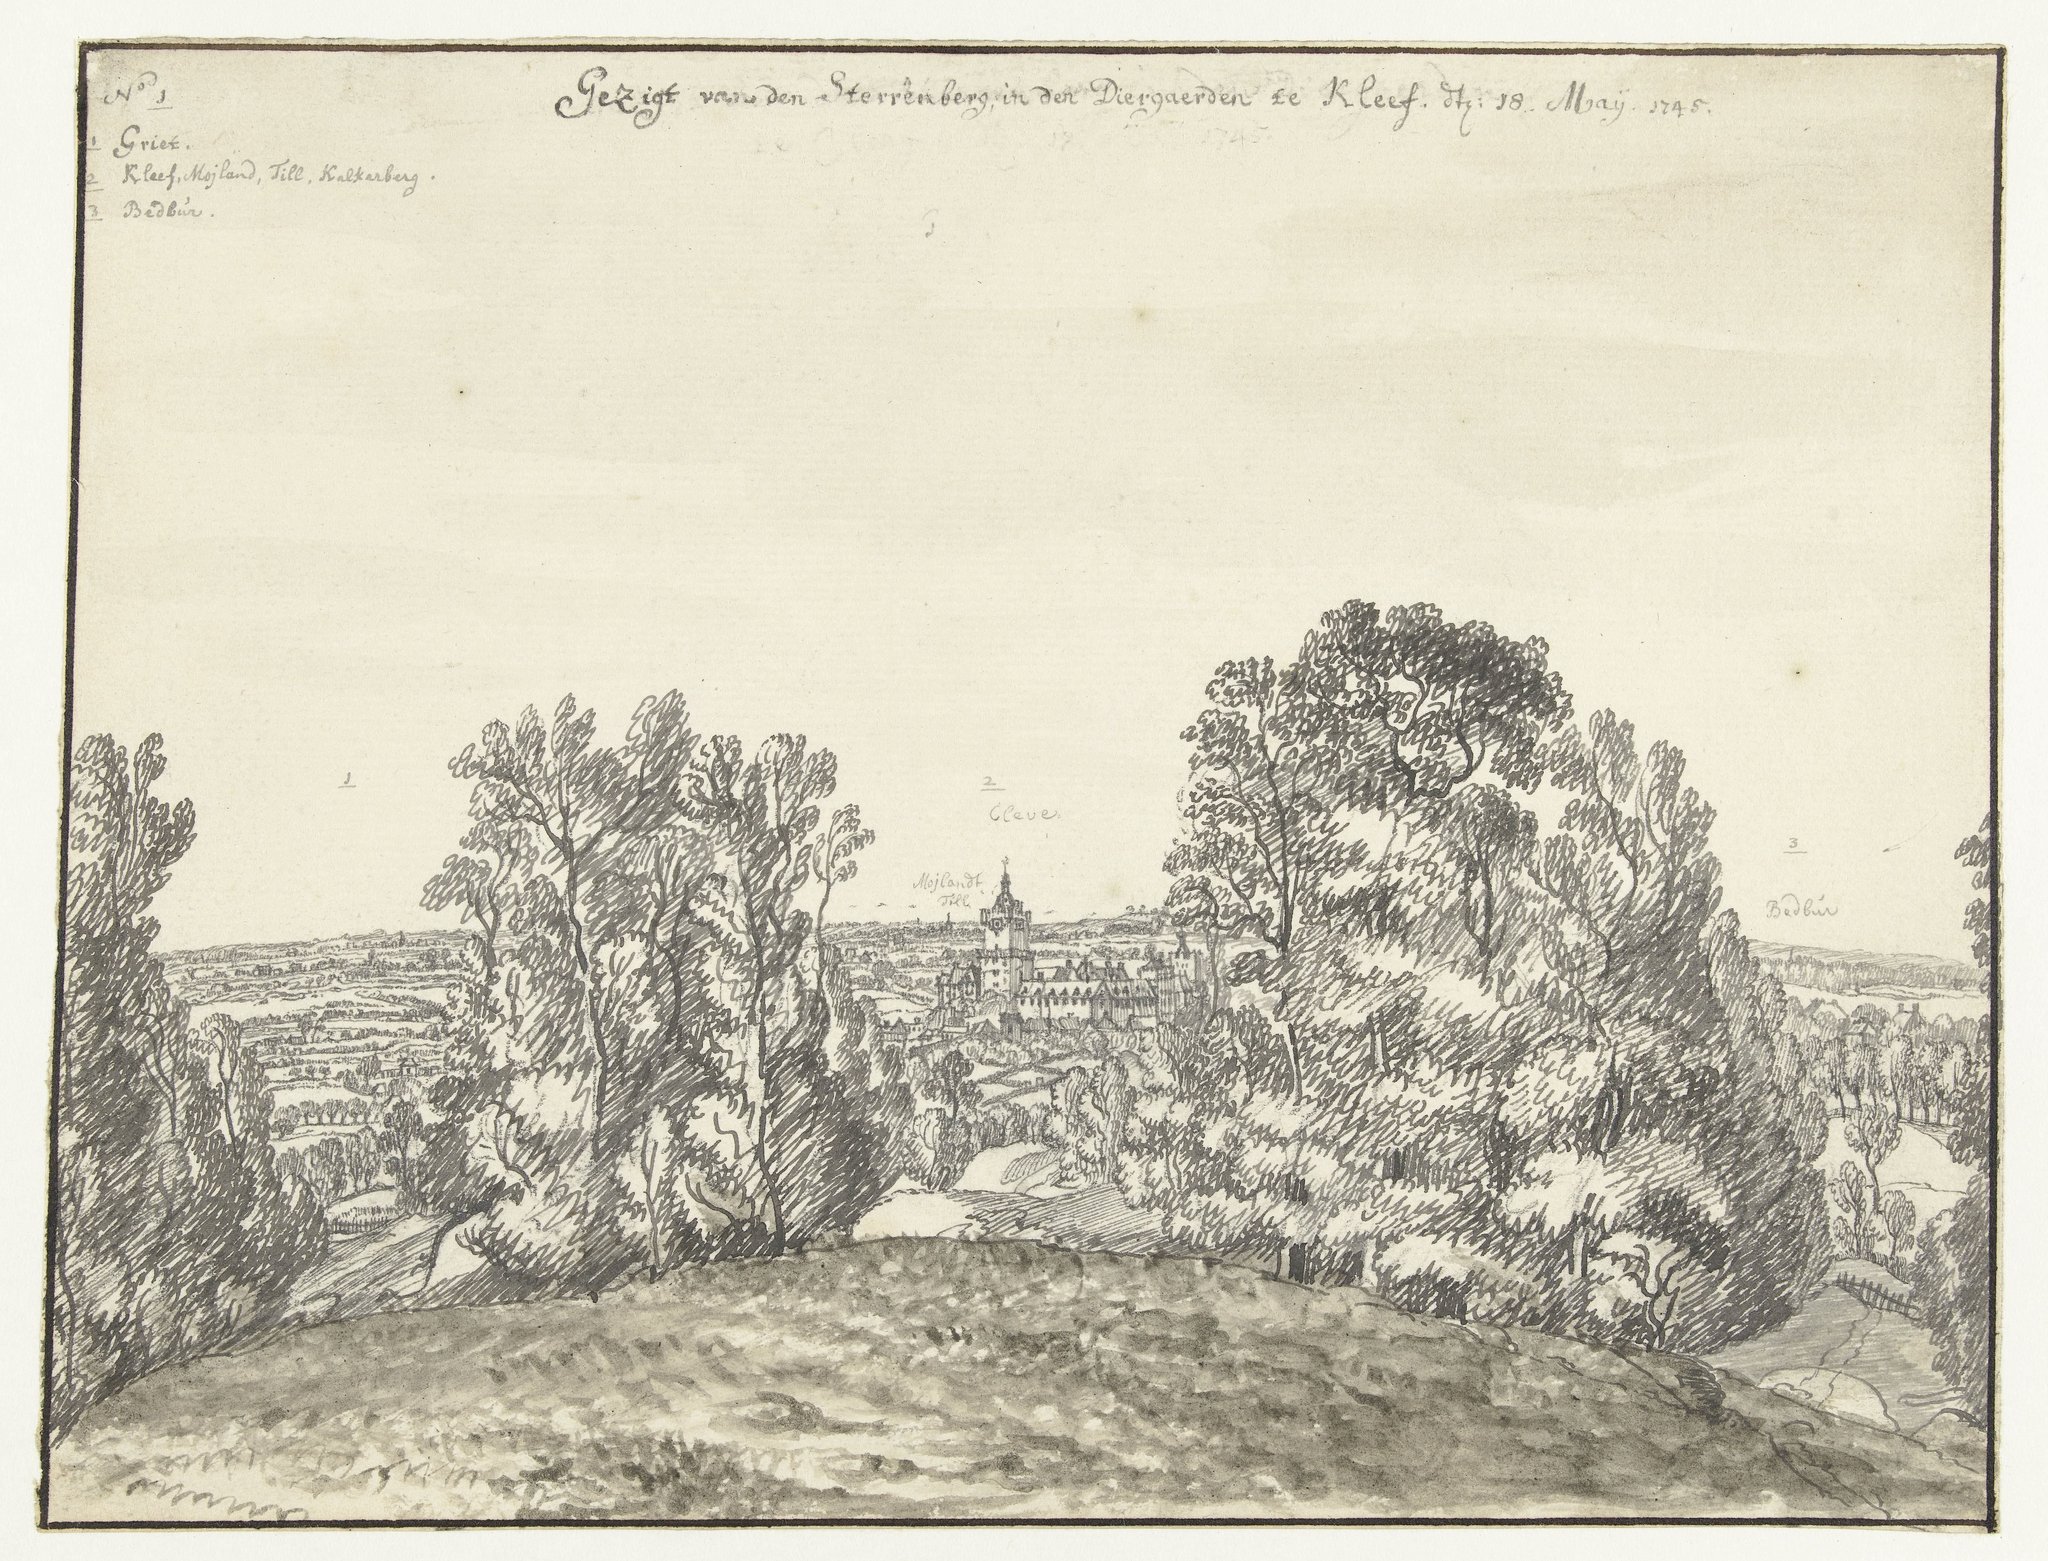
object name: drawing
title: Gezicht van de Sterrenberg op Kleef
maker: jan de beijer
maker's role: draughtsman, print maker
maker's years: 1703-1780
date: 1745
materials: chalk, ink, paper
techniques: brush, pen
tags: prospect of city, town panorama, silhouette of city, cleves